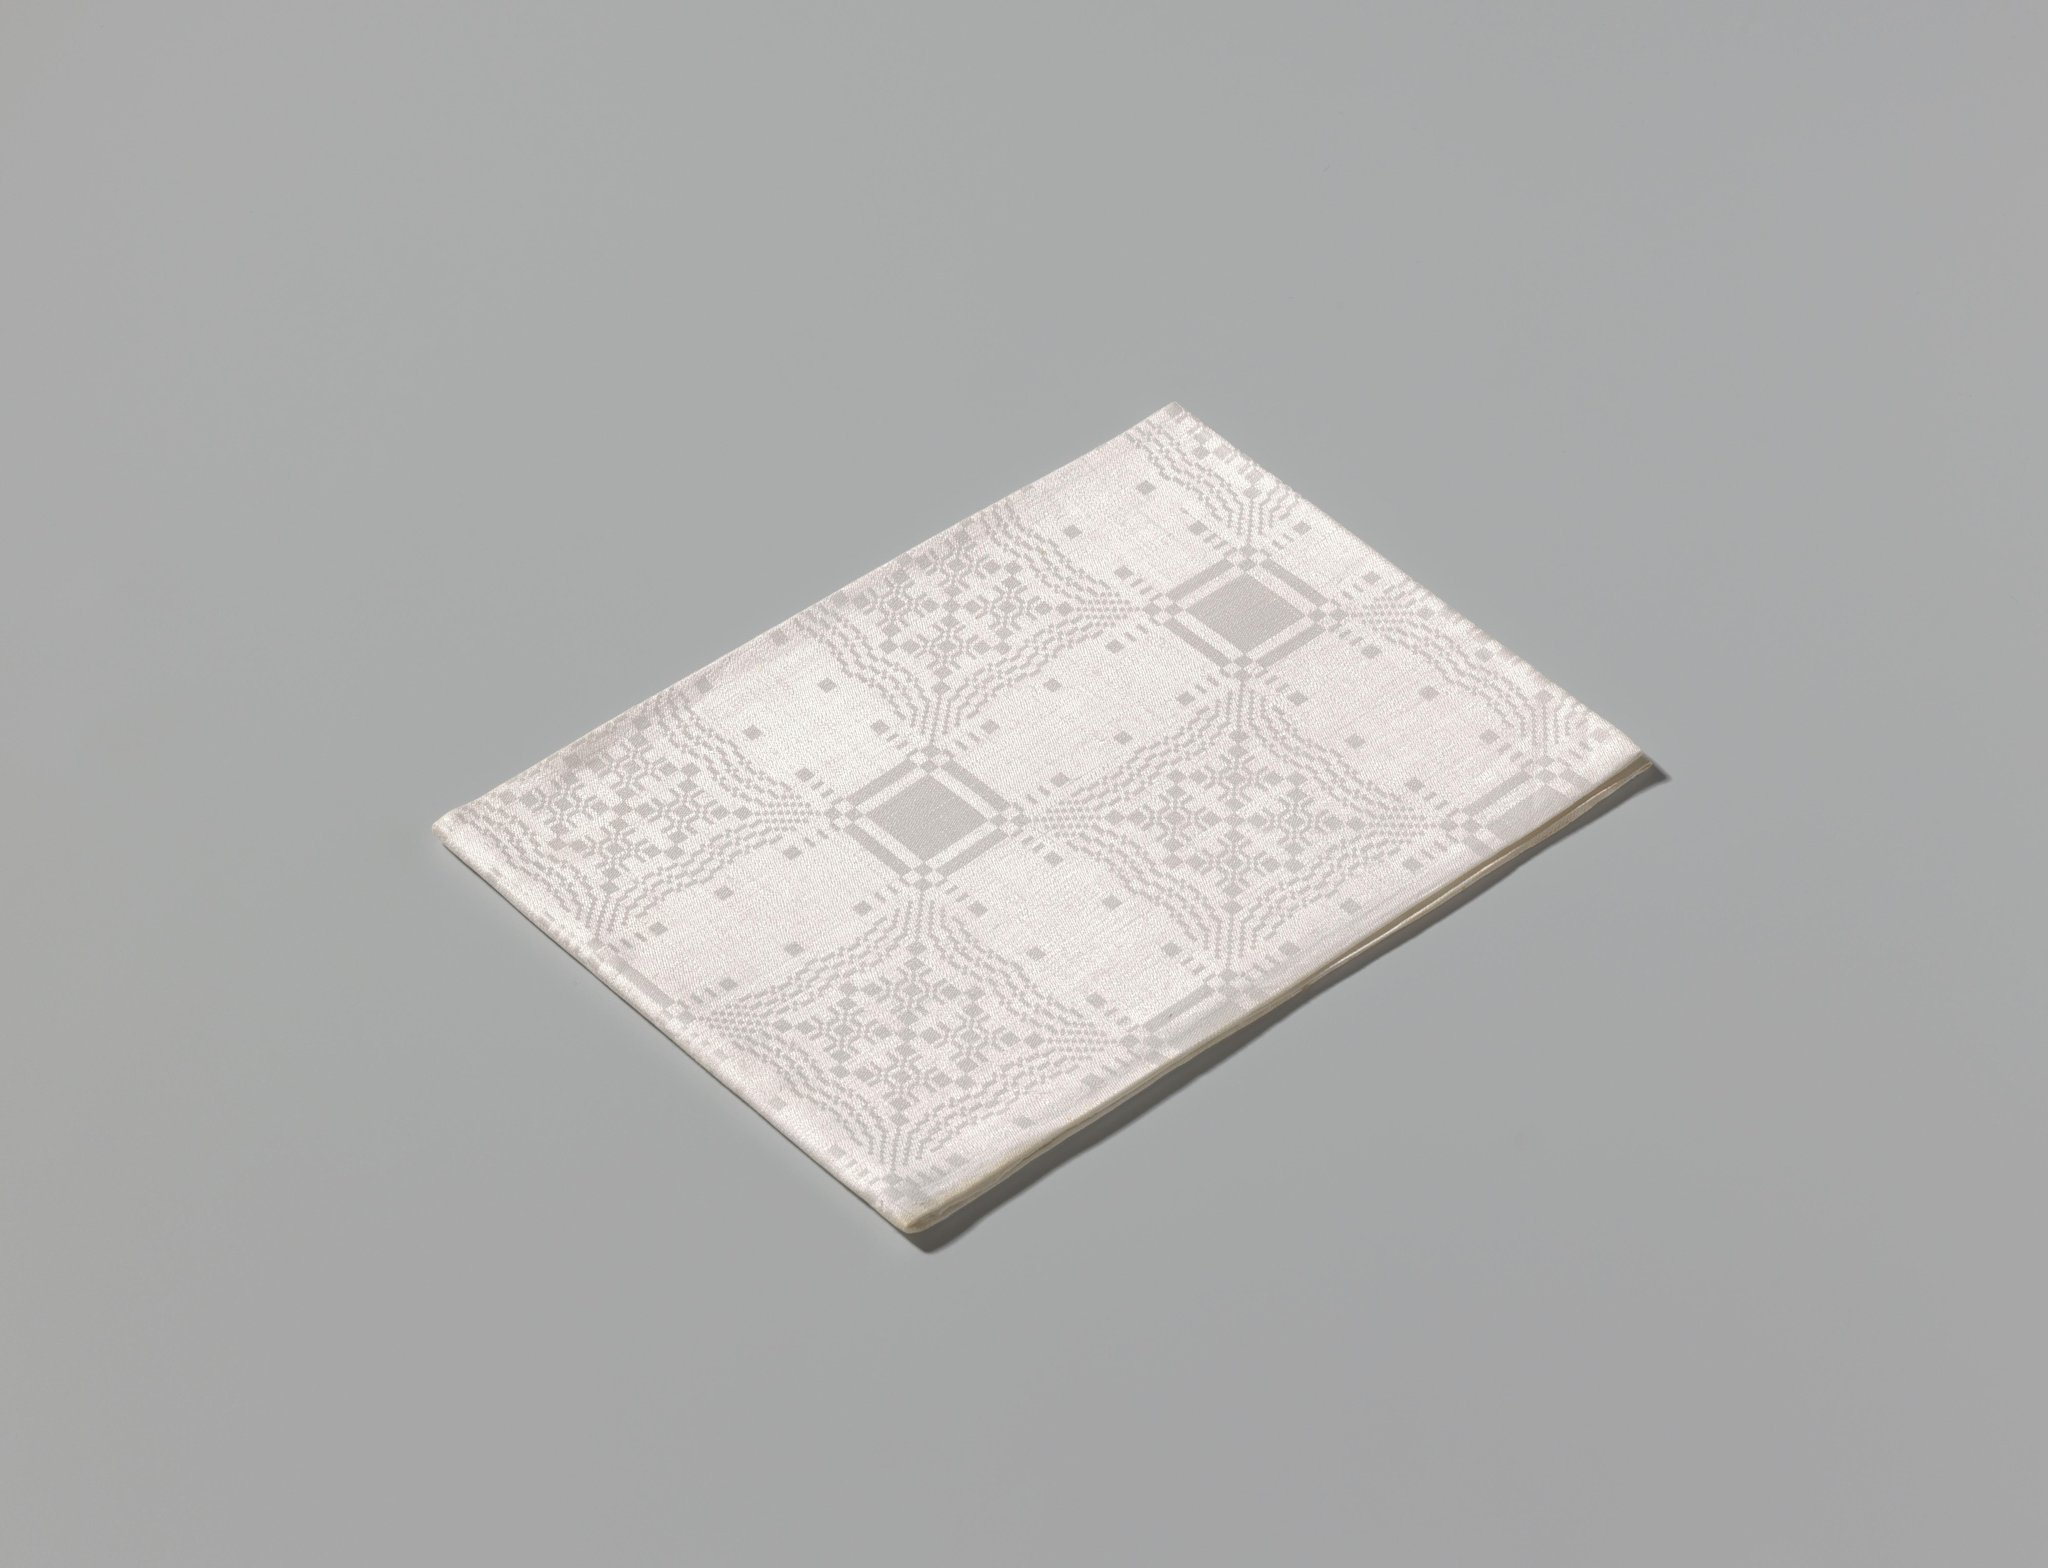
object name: napkin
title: Servet van linnen met pellenpatroon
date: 1734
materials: linen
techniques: peeled fabric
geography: northern netherlands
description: wit linnen servet met pellen patroon, merk AVG 38 en 1734